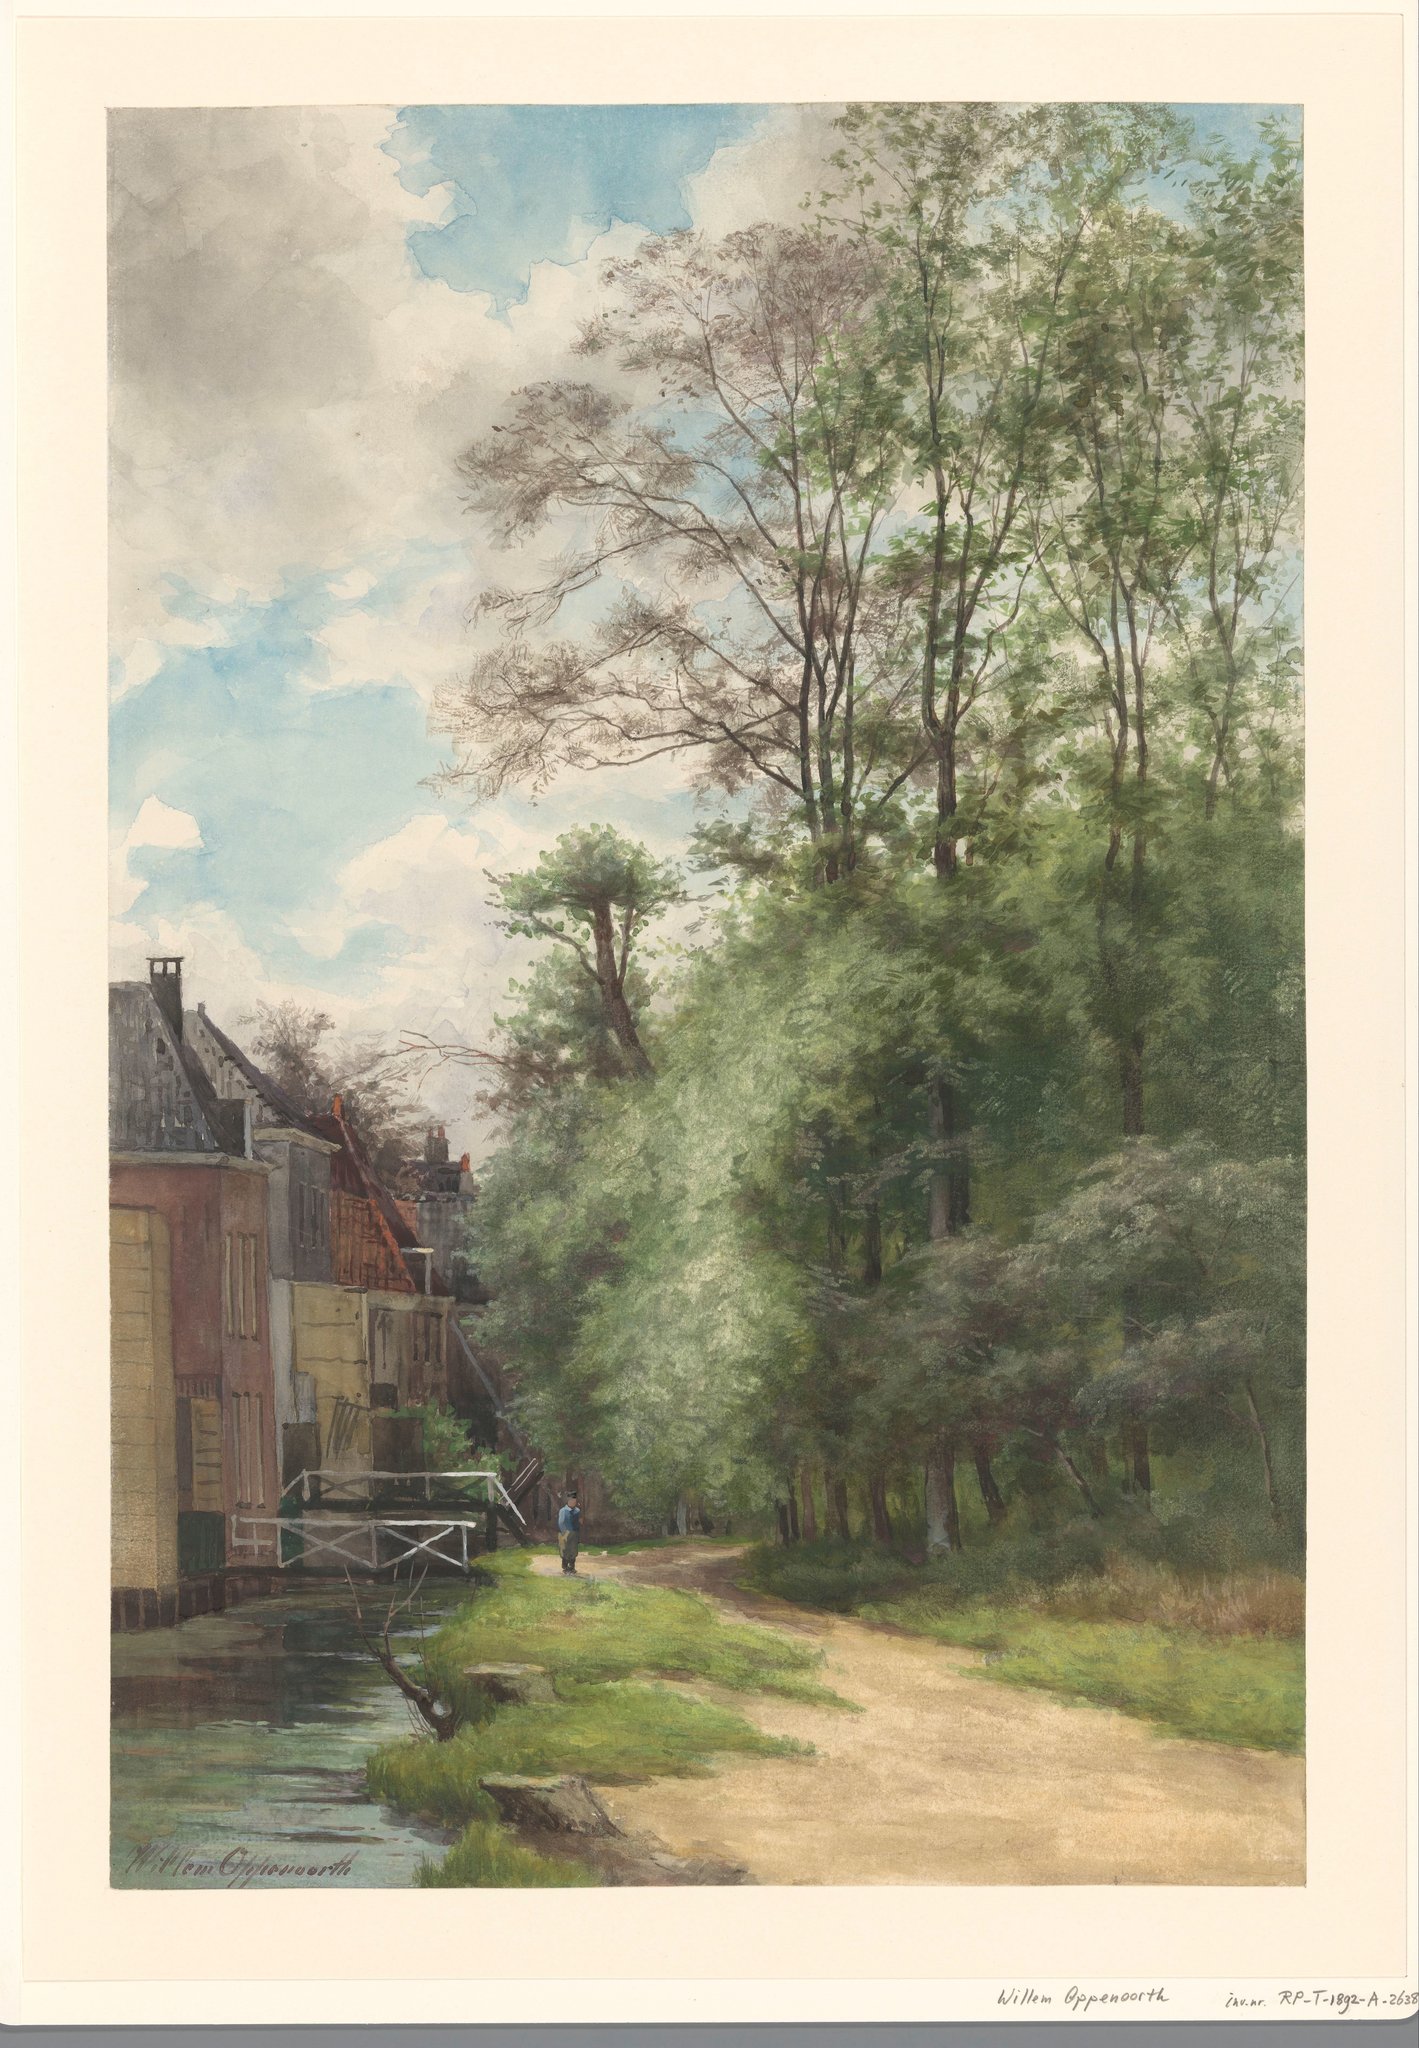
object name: watercolor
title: Gezicht langs de sloot bij het Bezuidenhout in het Haagse Bos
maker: willem oppenoorth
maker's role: draughtsman, painter, print maker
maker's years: 1847-1905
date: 1857-1892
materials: paper, watercolor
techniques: brush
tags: forest, wood, the hague